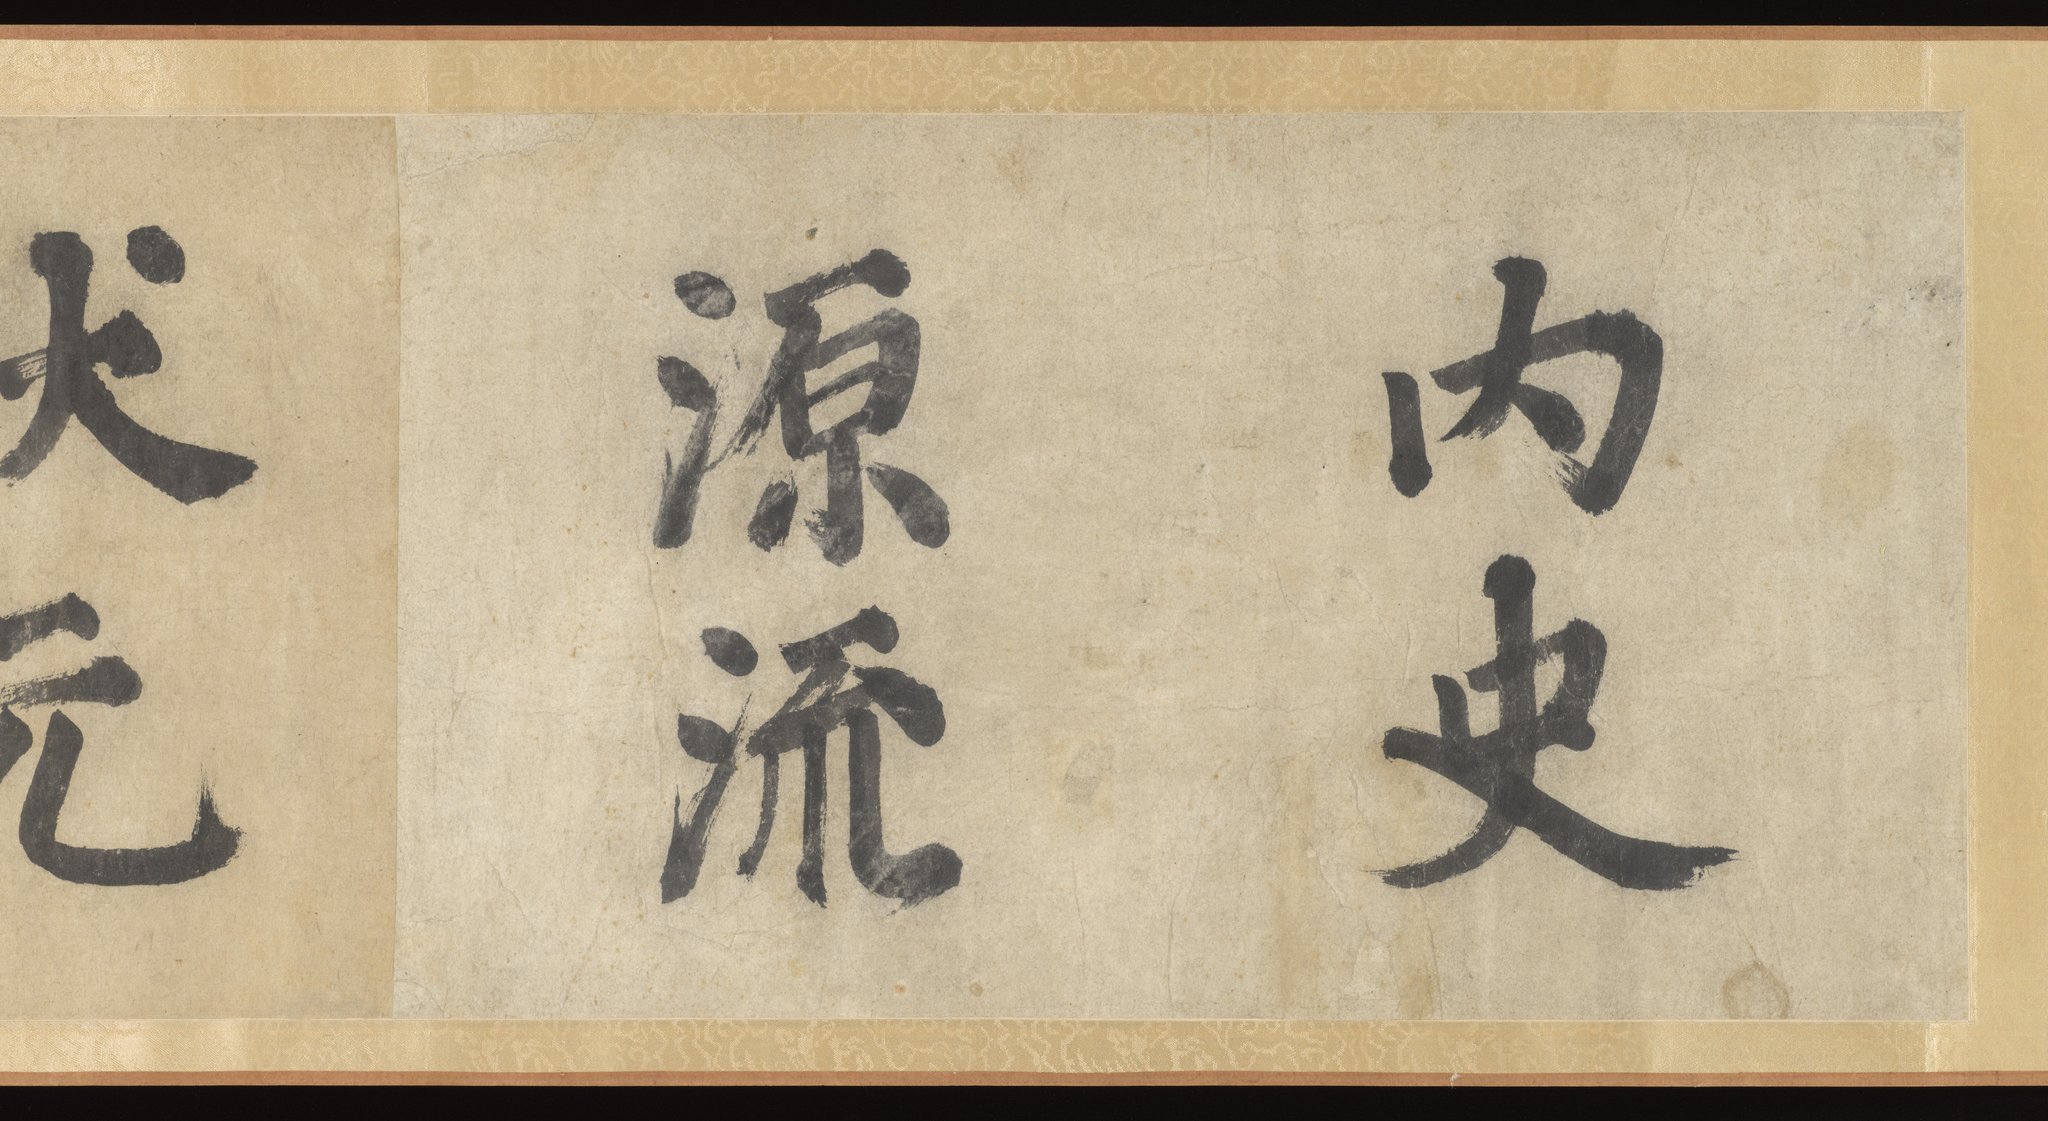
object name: handscroll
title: Genealogy with Portraits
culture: chinese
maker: unidentified artist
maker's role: artist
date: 960-1279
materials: ink, paper